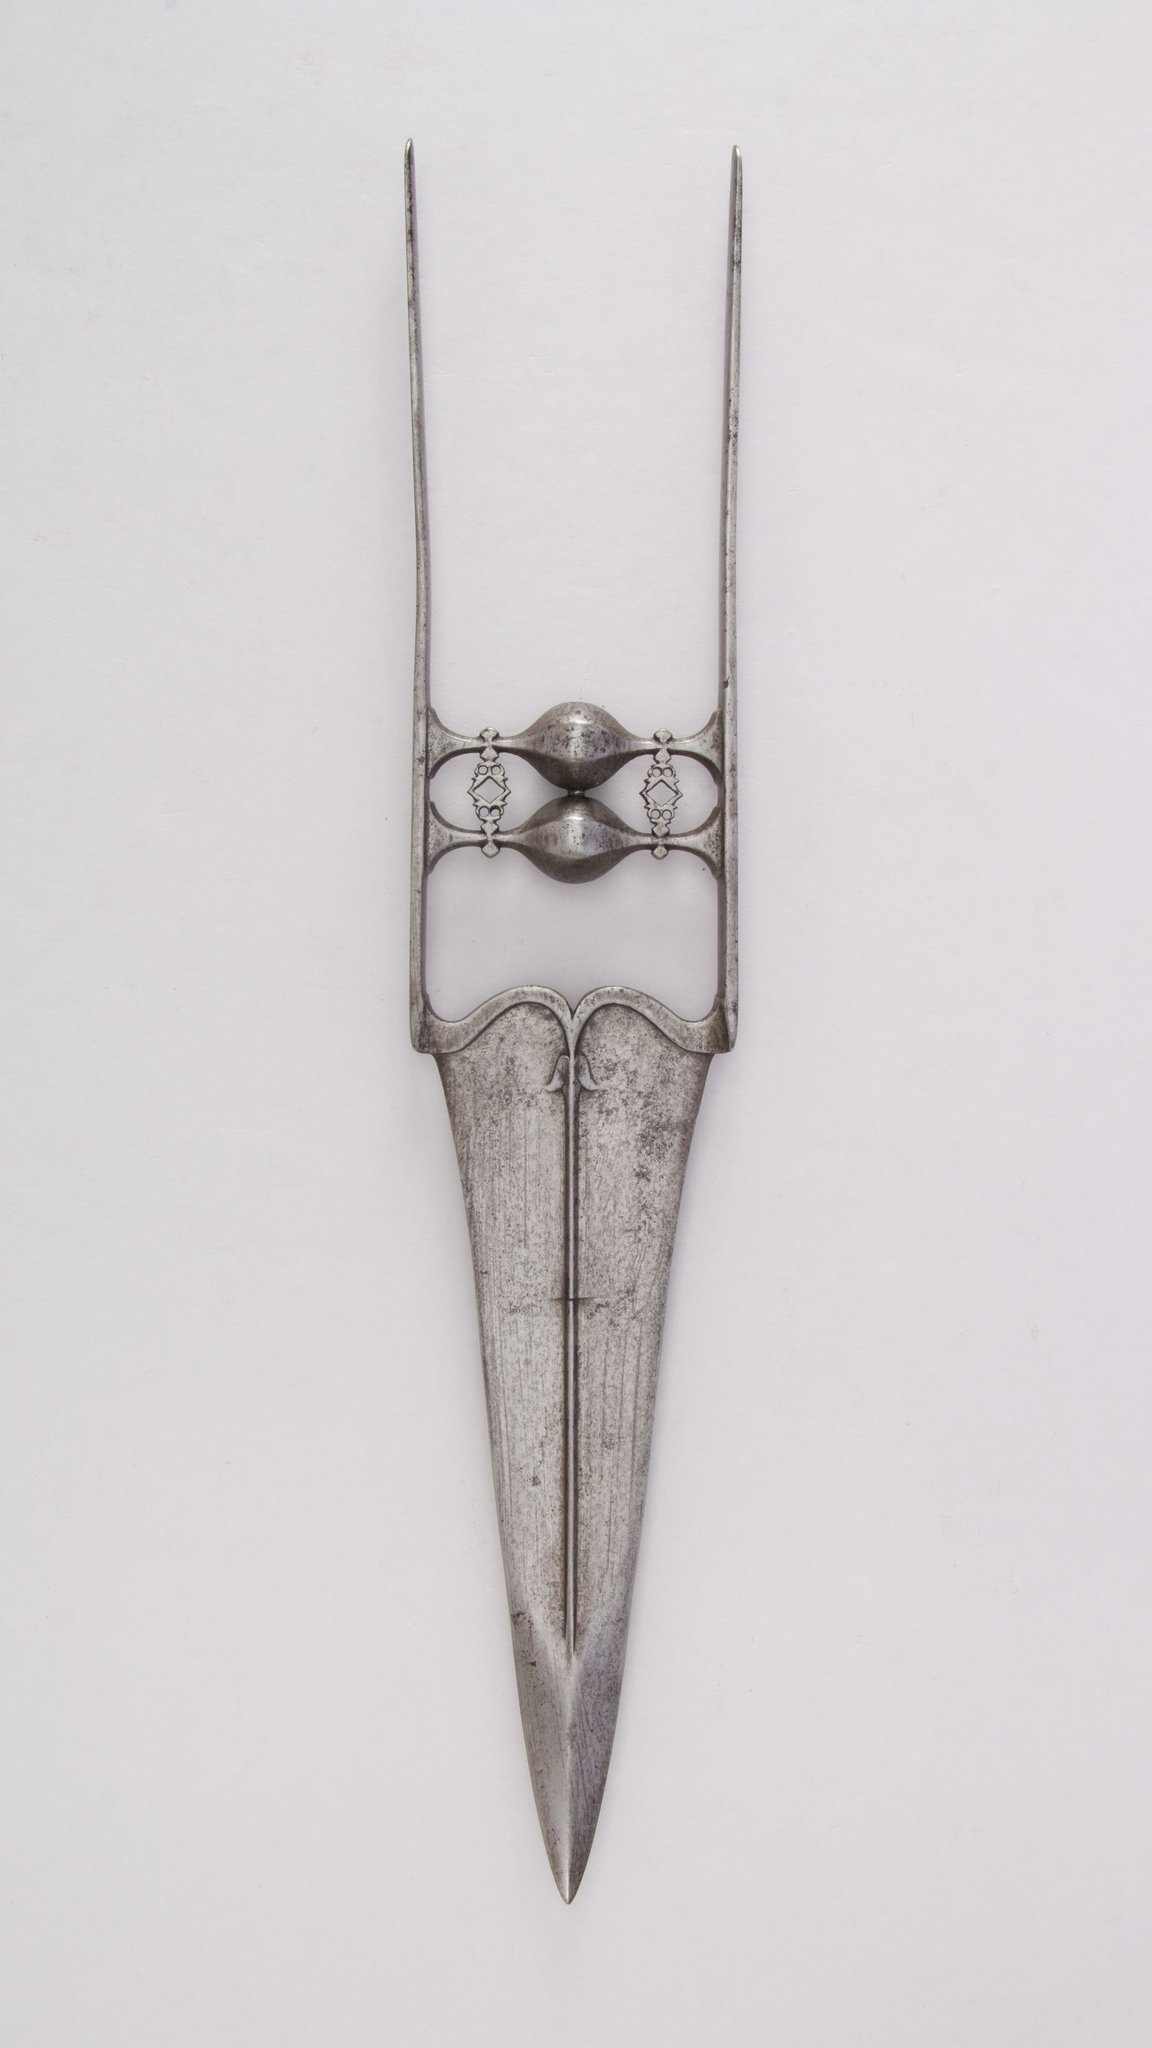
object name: dagger katar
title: Dagger (Katar)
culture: indian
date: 1601-1800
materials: steel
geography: south india